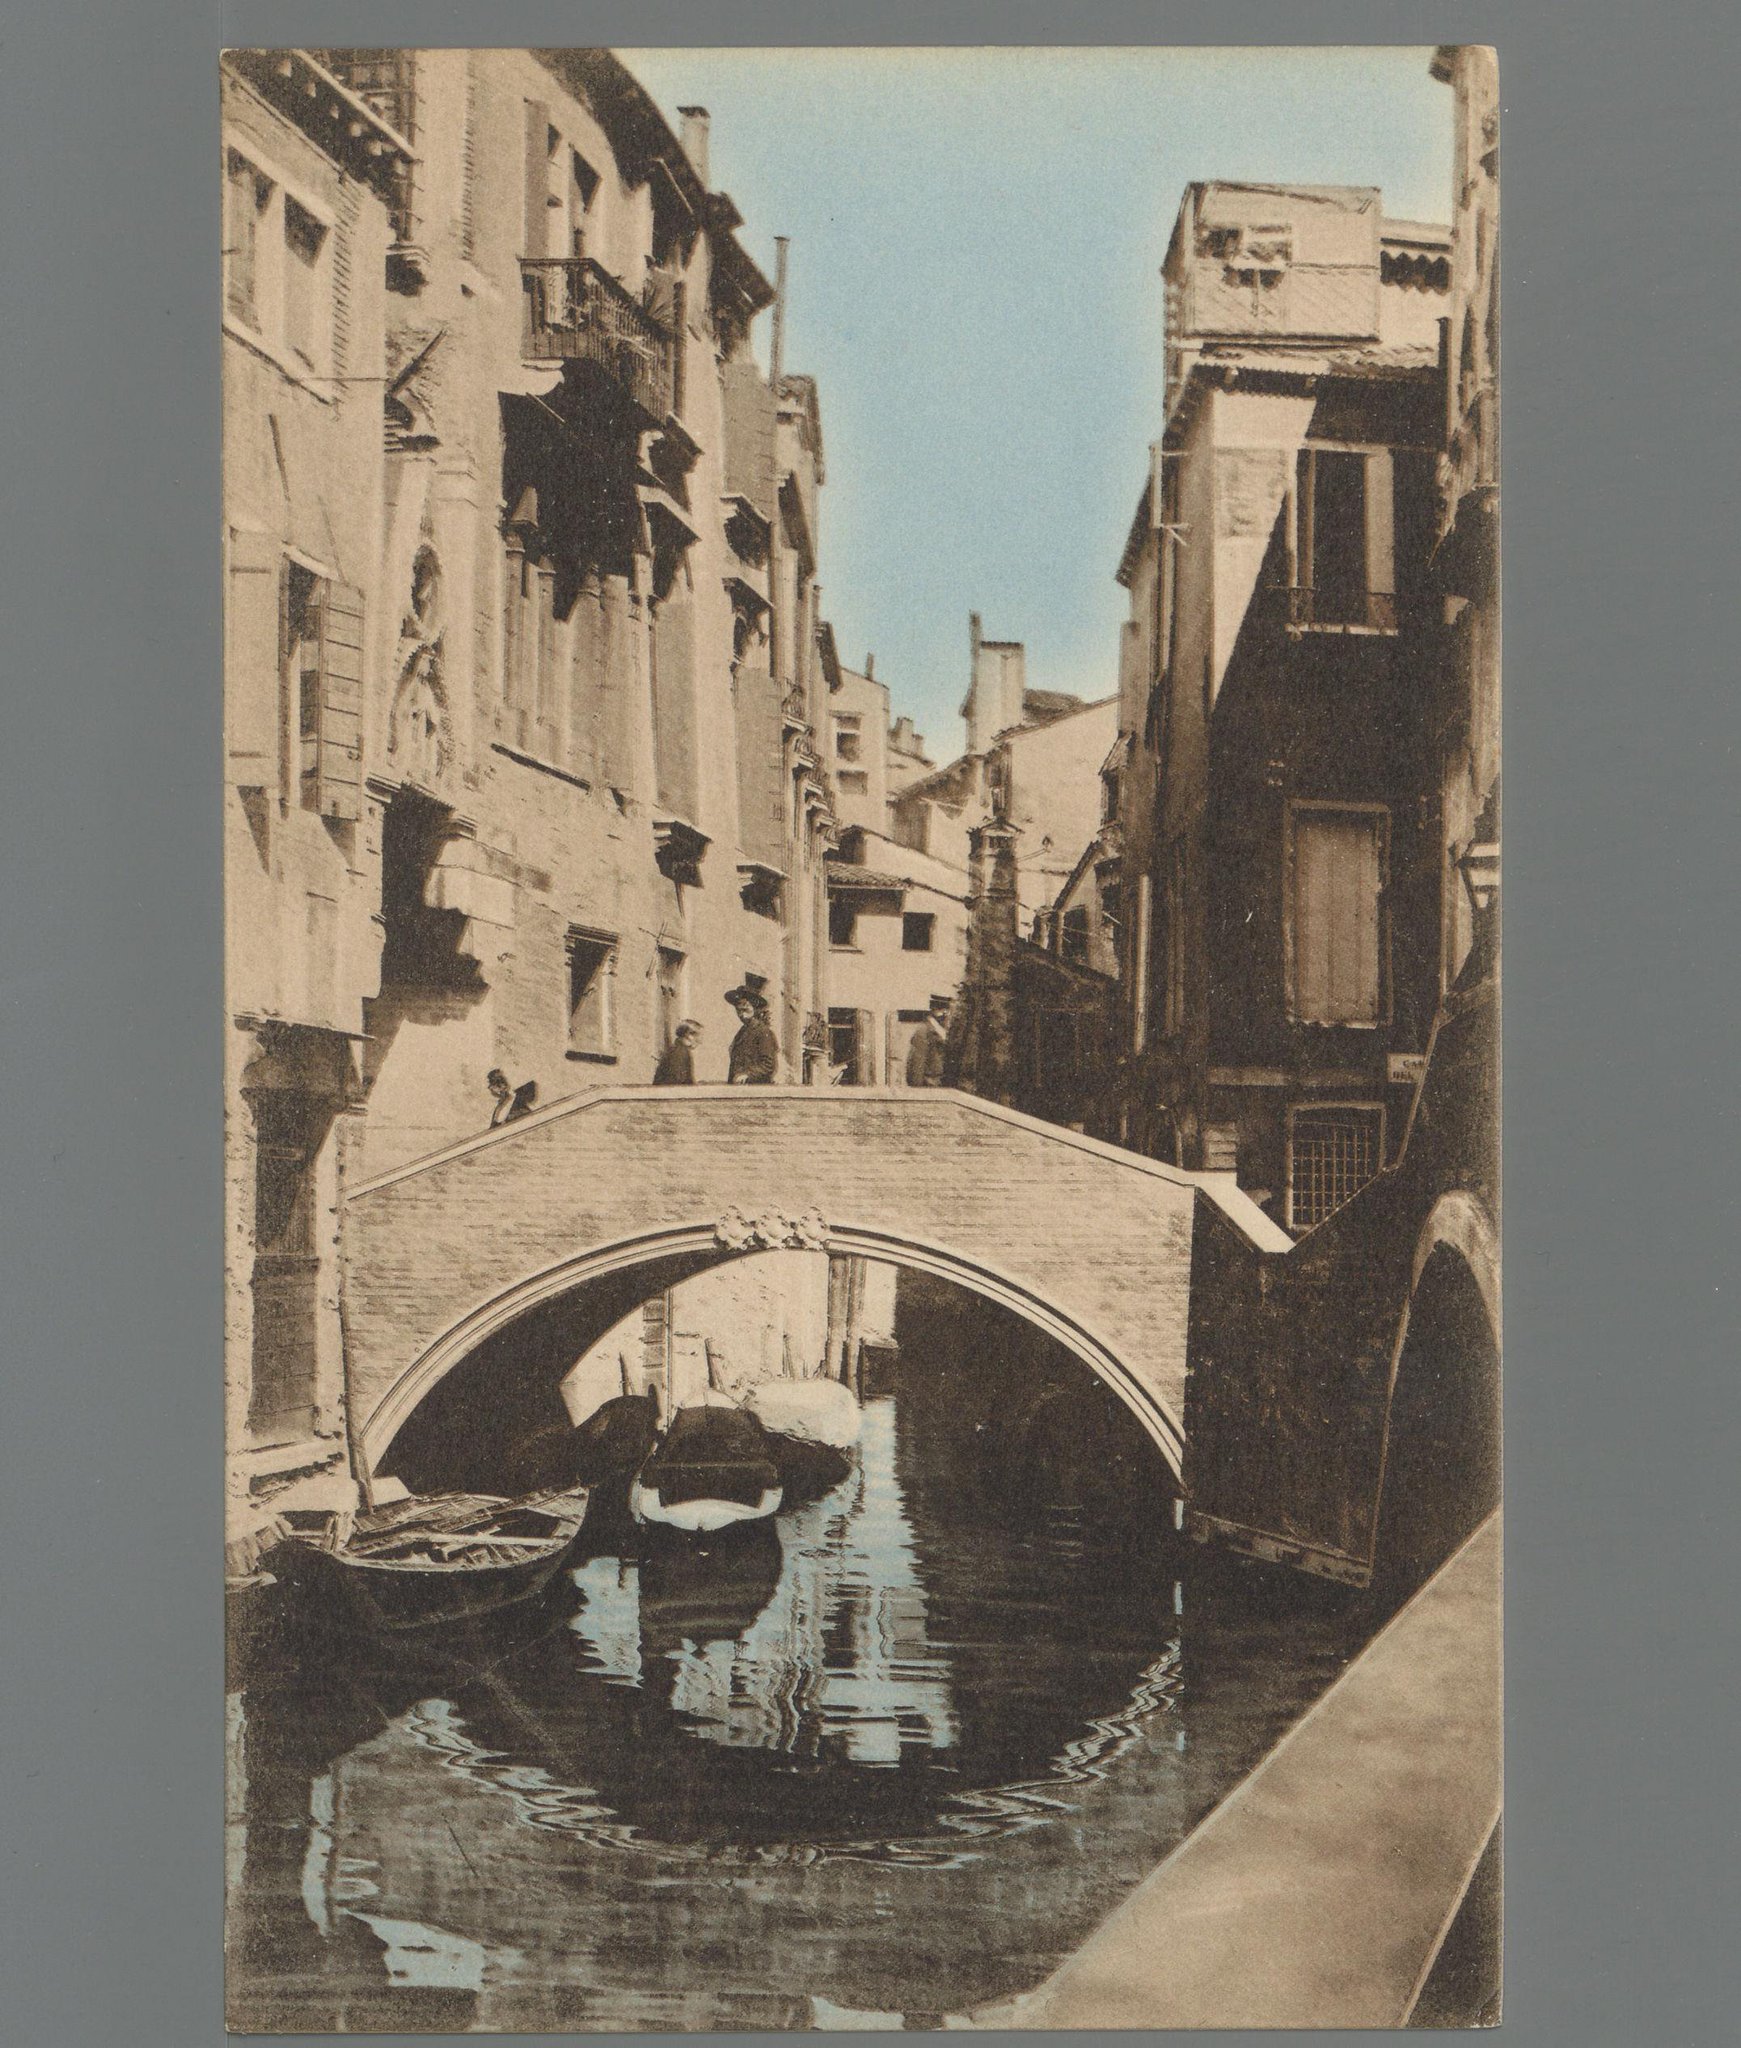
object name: photomechanical print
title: Venezia. Ponte dei Paradiso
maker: Anonymous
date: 1906-1920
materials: cardboard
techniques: photograph, lithograph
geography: venice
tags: bridge in city across river, canal, etc. (+ city(-scape) with figures, staffage), city-view, and landscape with man-made constructions (+ city(-scape) with figures, staffage), venice